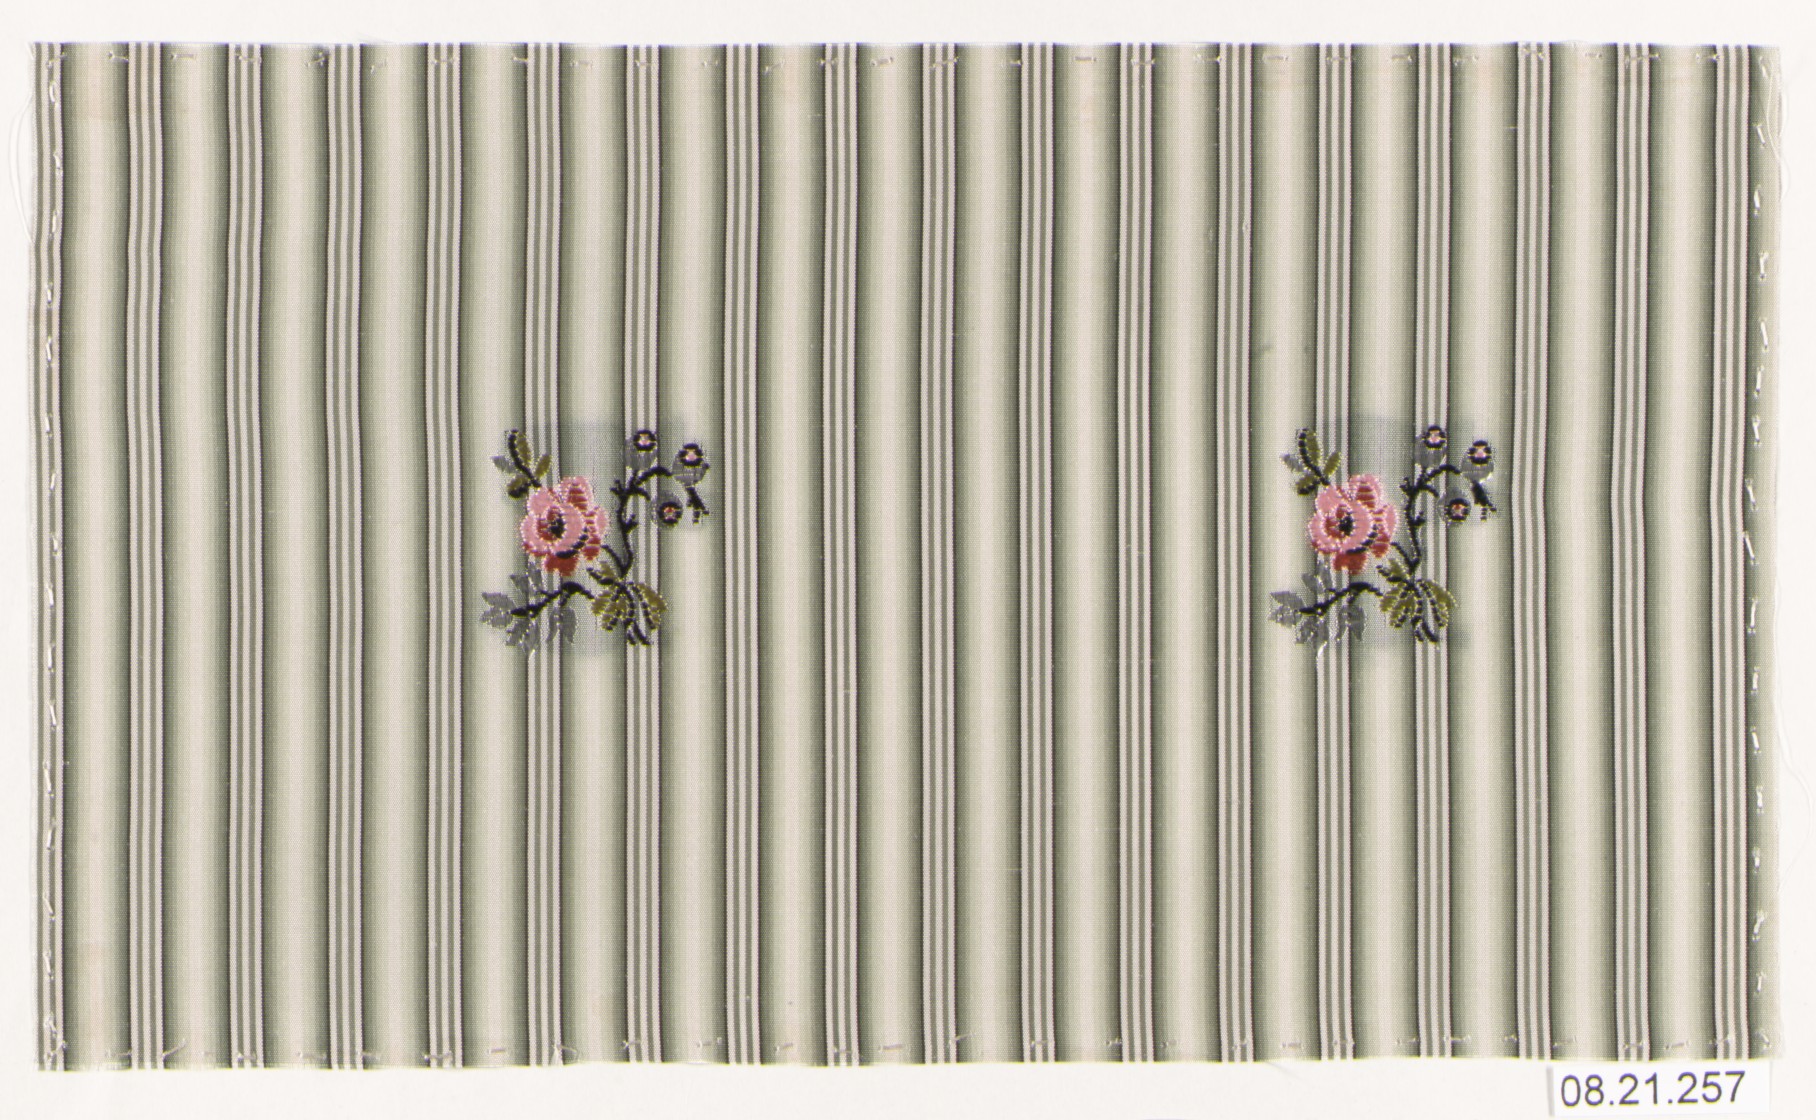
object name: textile sample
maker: Anonymous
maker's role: designer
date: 1900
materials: silk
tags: flowers